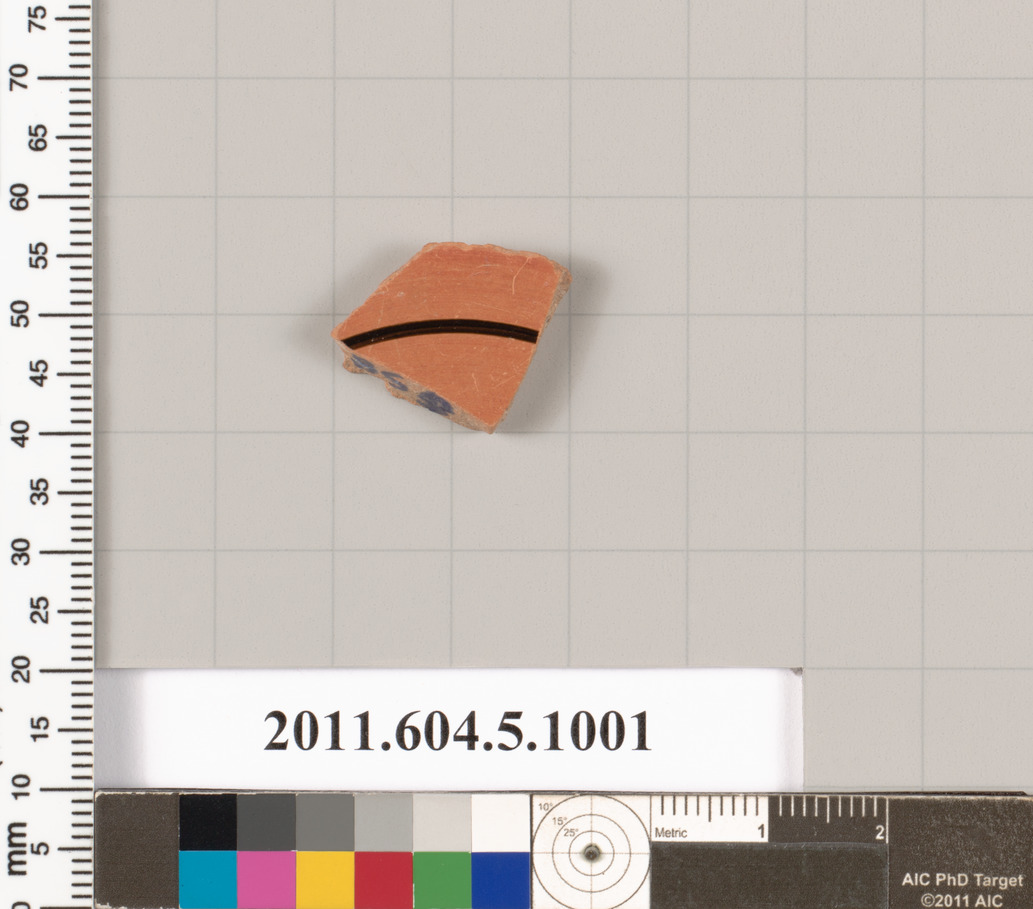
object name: kylix fragment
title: Terracotta fragment of a kylix (drinking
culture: greek, attic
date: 600-401 BCE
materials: terracotta